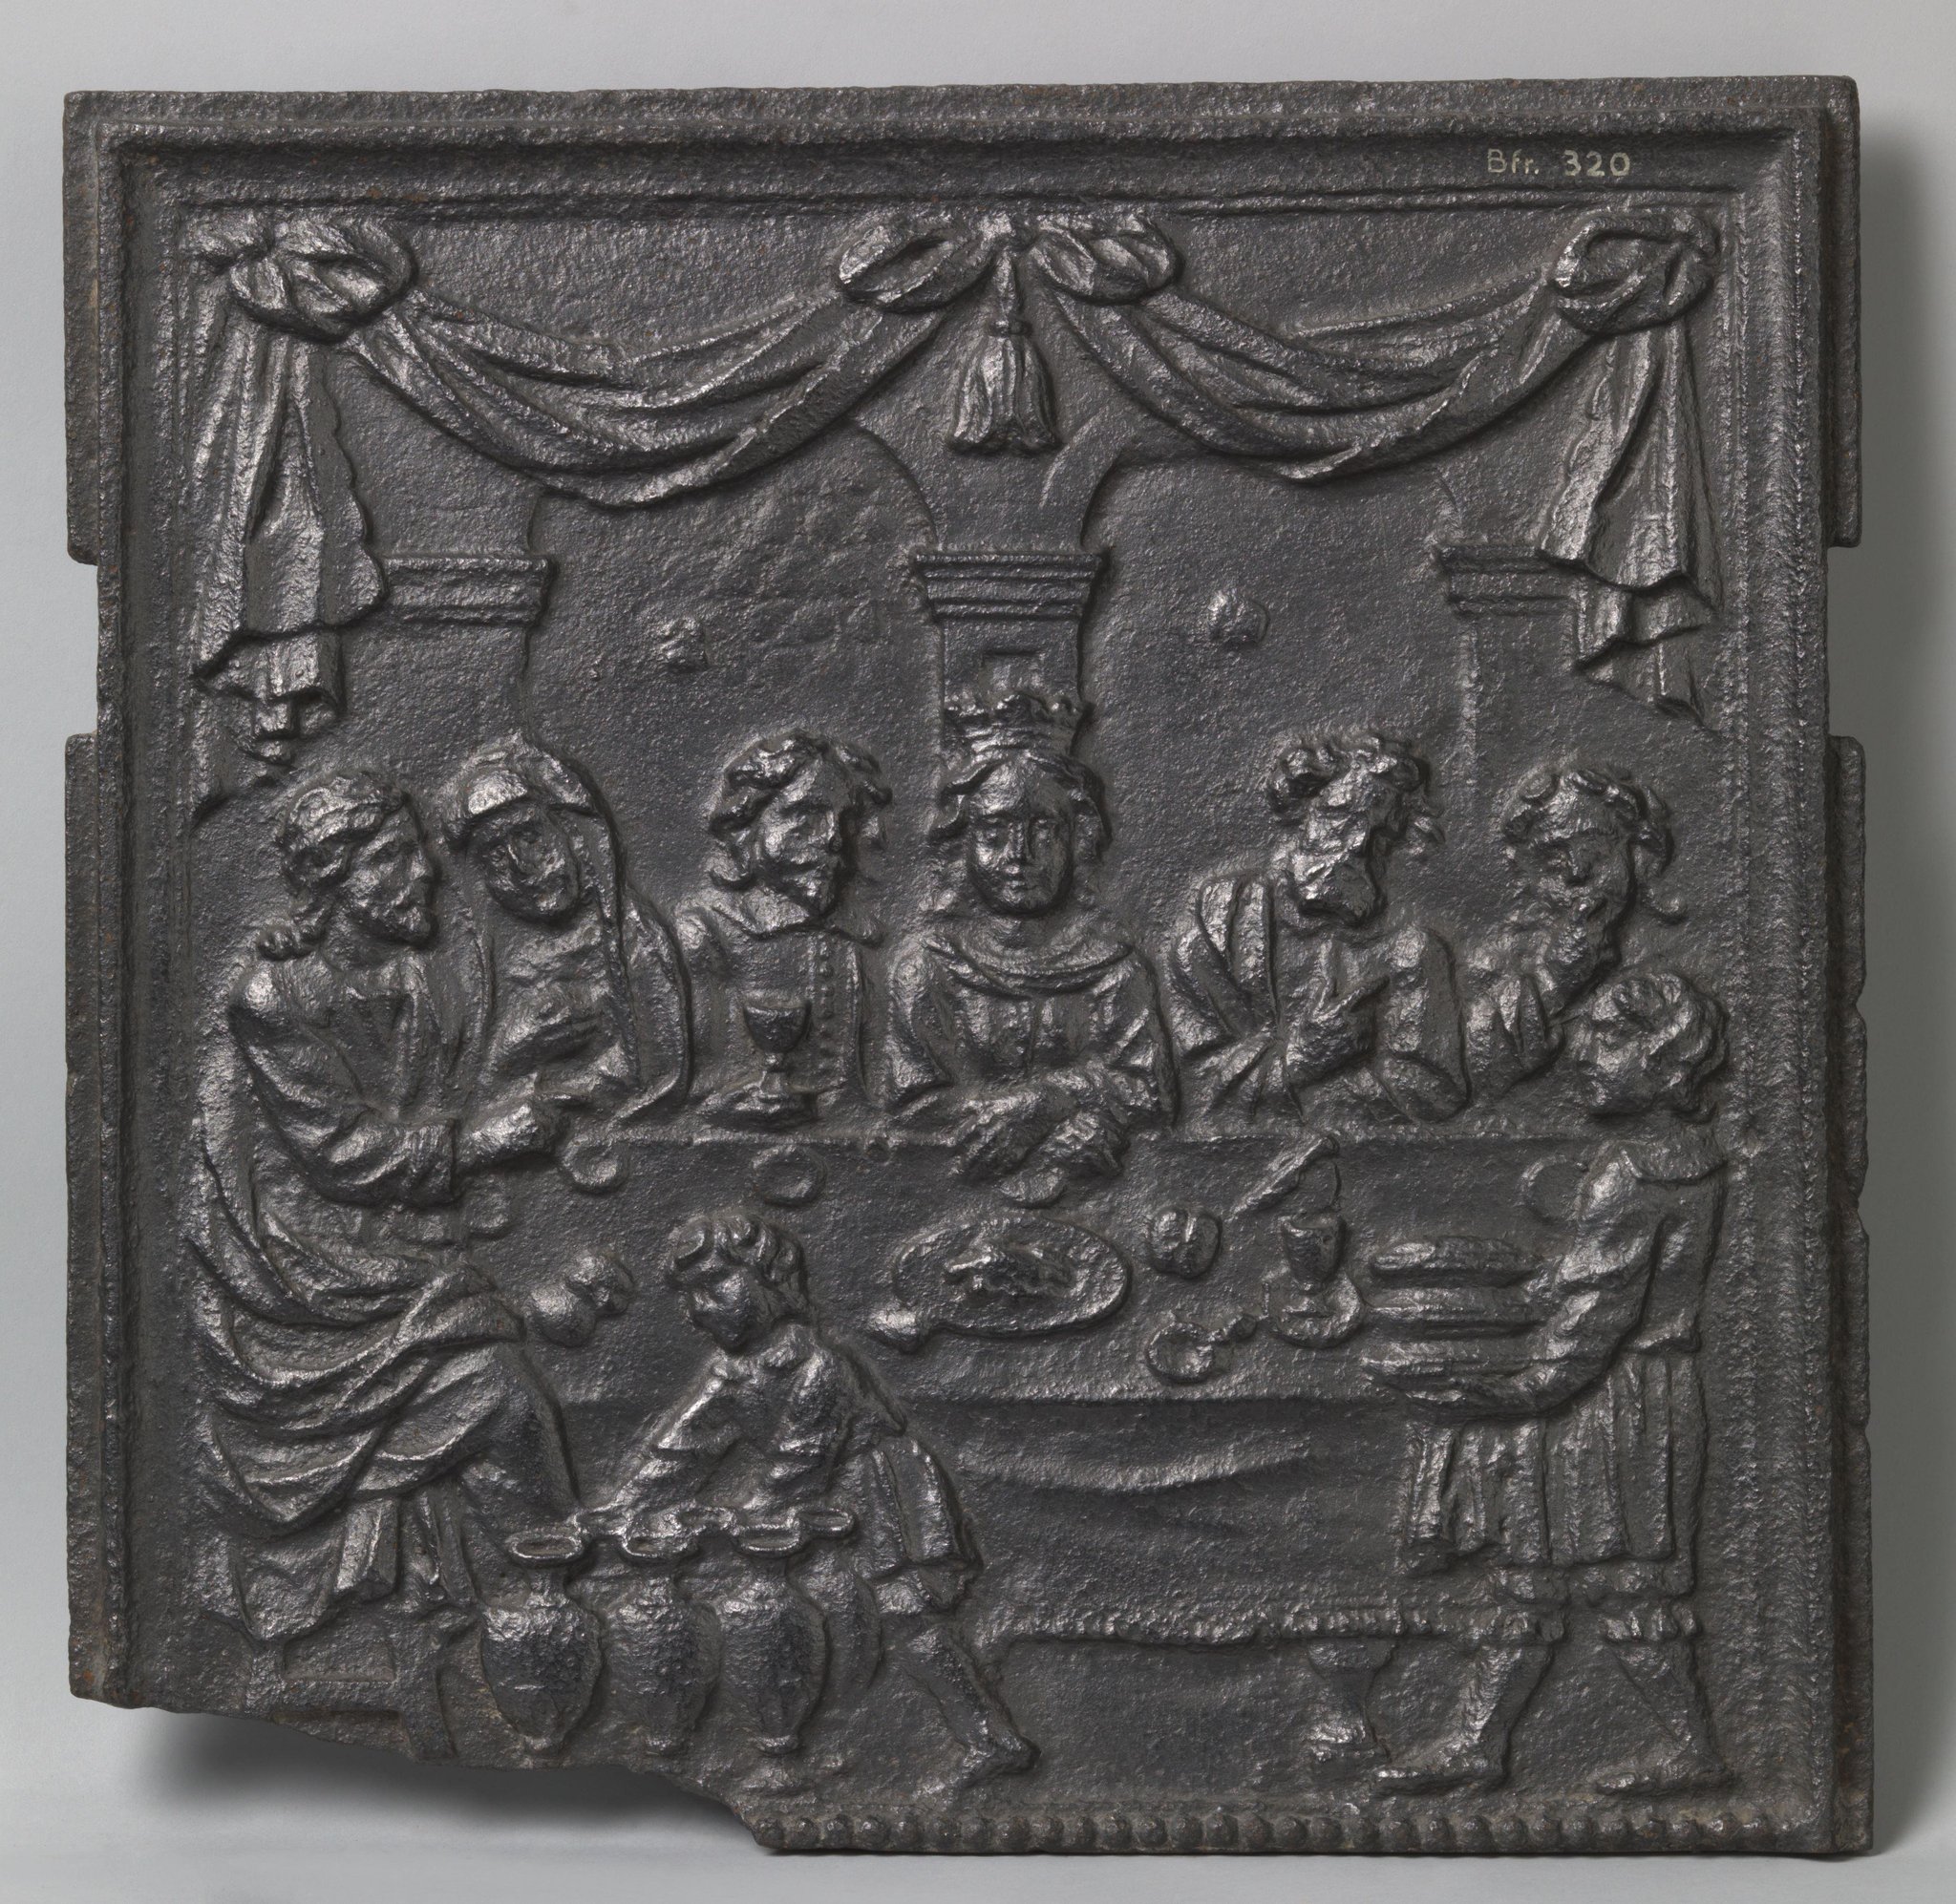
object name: stove plate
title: Kachelplaat met een voorstelling van de bruiloft te Kana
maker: Anonymous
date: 1550-1650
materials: iron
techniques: casting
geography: eifel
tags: the marriage-feast at cana (john 2:1-11)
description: Gietijzeren kachelplaat, verdeeld in twee zones. In de bovenste zone is de bruiloft te Kana afgebeeld. Centraal is de lange, gedekte tafel te zien, waaraan de gasten zitten. Midden aan tafel zit de bruid met een kroon op haar hoofd. Geheel links zit Jezus. Op de voorgrond staat een van de bedienden bij de zes kruiken en brengt een andere bediende schalen naar tafel. Het tafereel wordt aan de onderzijde afgesloten met een parelrand. De onderste zone is een los deel, genummerd BK-BFR-336.